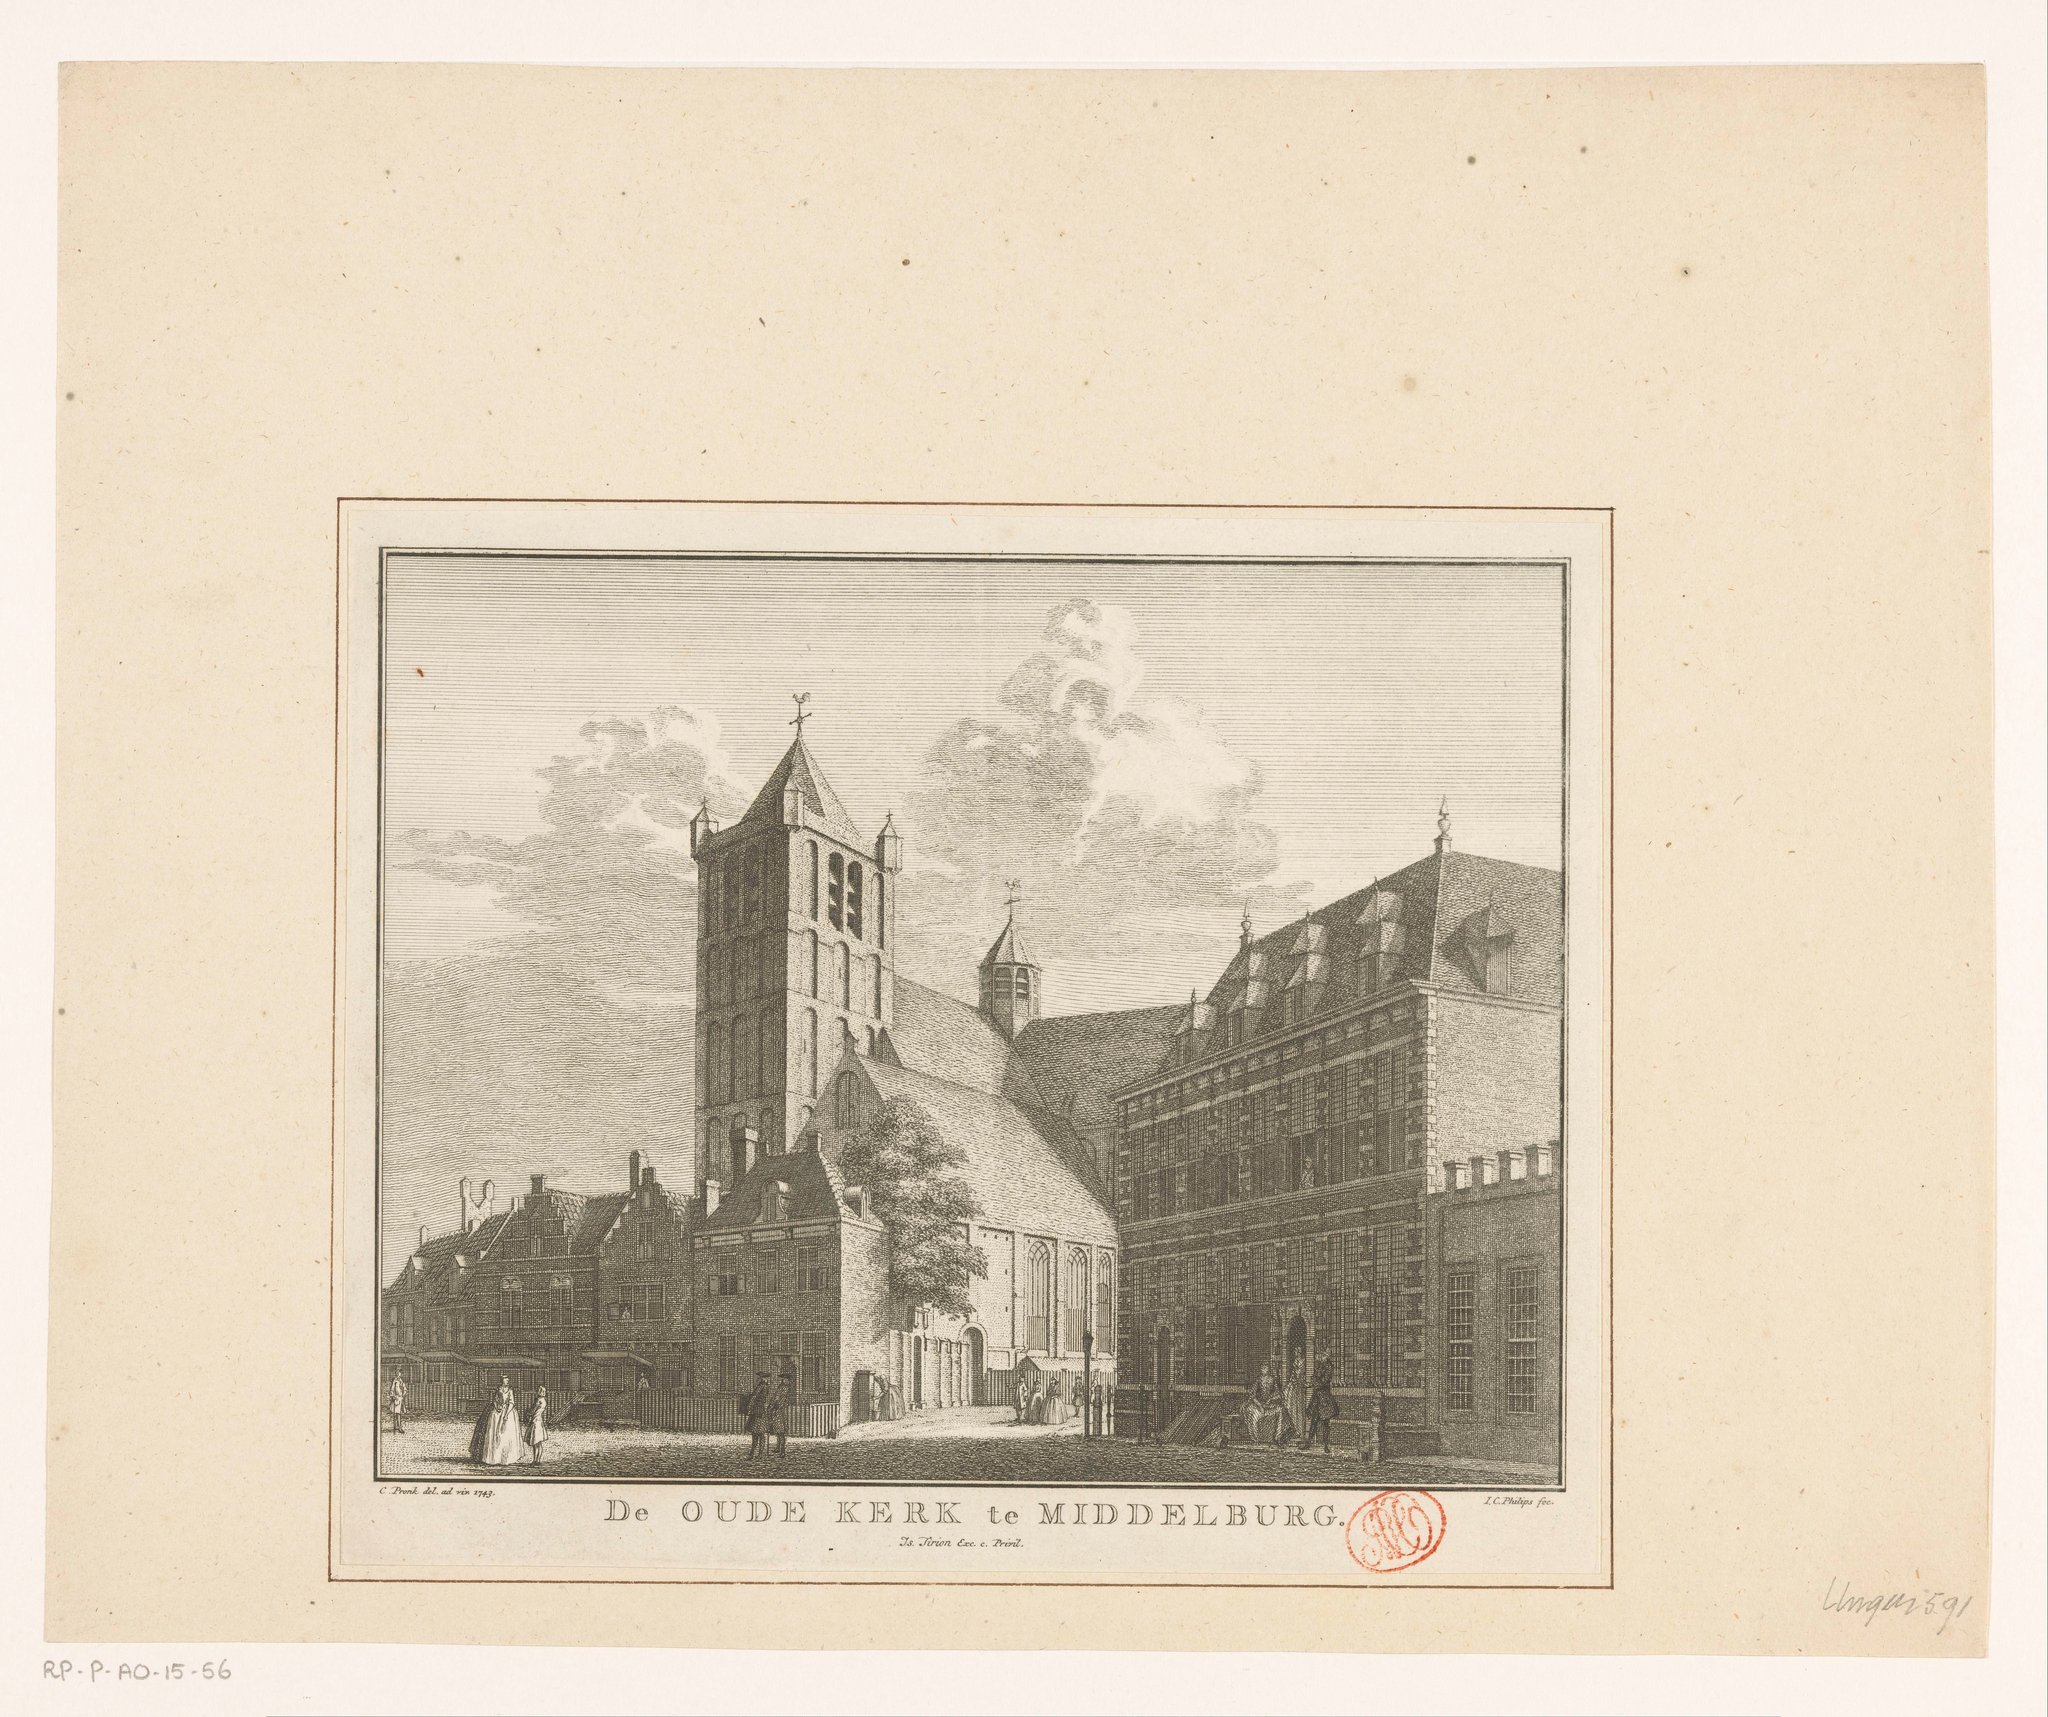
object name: print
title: De Oude Kerk te Middelburg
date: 1751-1760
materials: paper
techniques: etching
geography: amsterdam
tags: church (exterior)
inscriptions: collector's mark: Lugt 195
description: Gezicht op de Noordmonsterkerk te Middelburg, in de situatie omstreeks 1743. Deze in 1835 gesloopte kerk stond ook bekend als de Oude Kerk en de Sint-Pieterskerk.